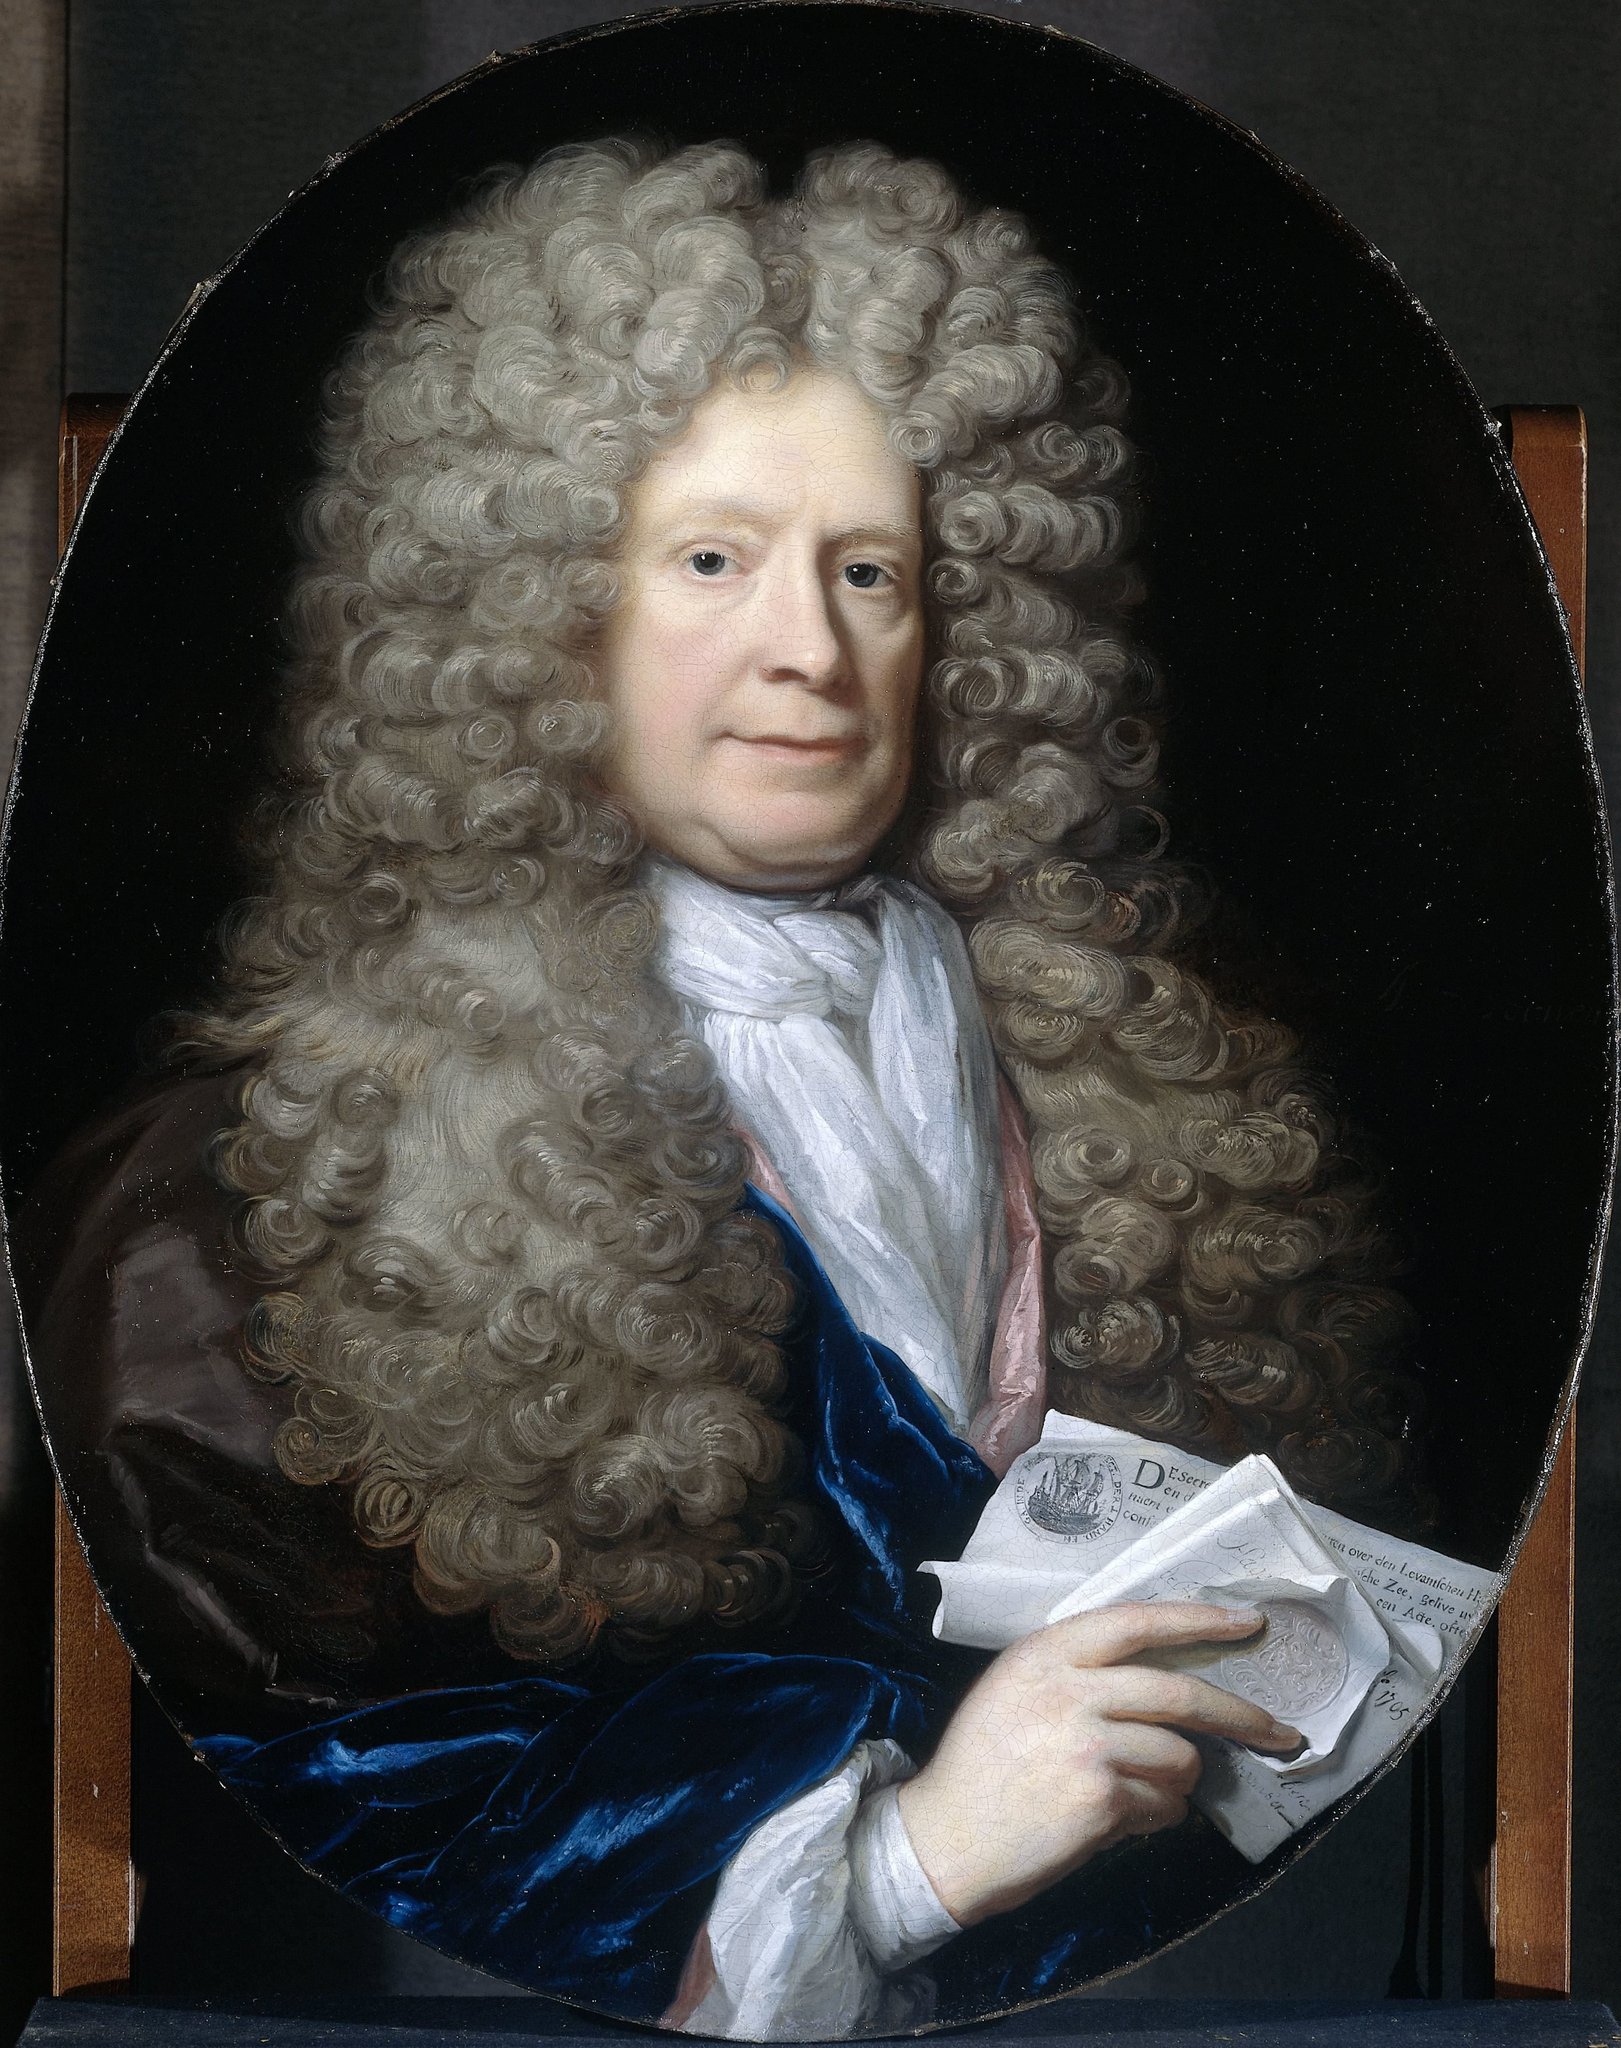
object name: painting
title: Portrait of Pieter van de Poel (1654-1710)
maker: arnold boonen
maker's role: draughtsman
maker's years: 1669-1729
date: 1705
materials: canvas, oil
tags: historical persons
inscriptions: signature: ‘A. Boone’, date, lower right, on the letter: ‘1705’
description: Arnold Boonen(1669 - 1729). Portrait of Pieter van de Poel. On loan from the Rijksdienst Beeldende Kunst.